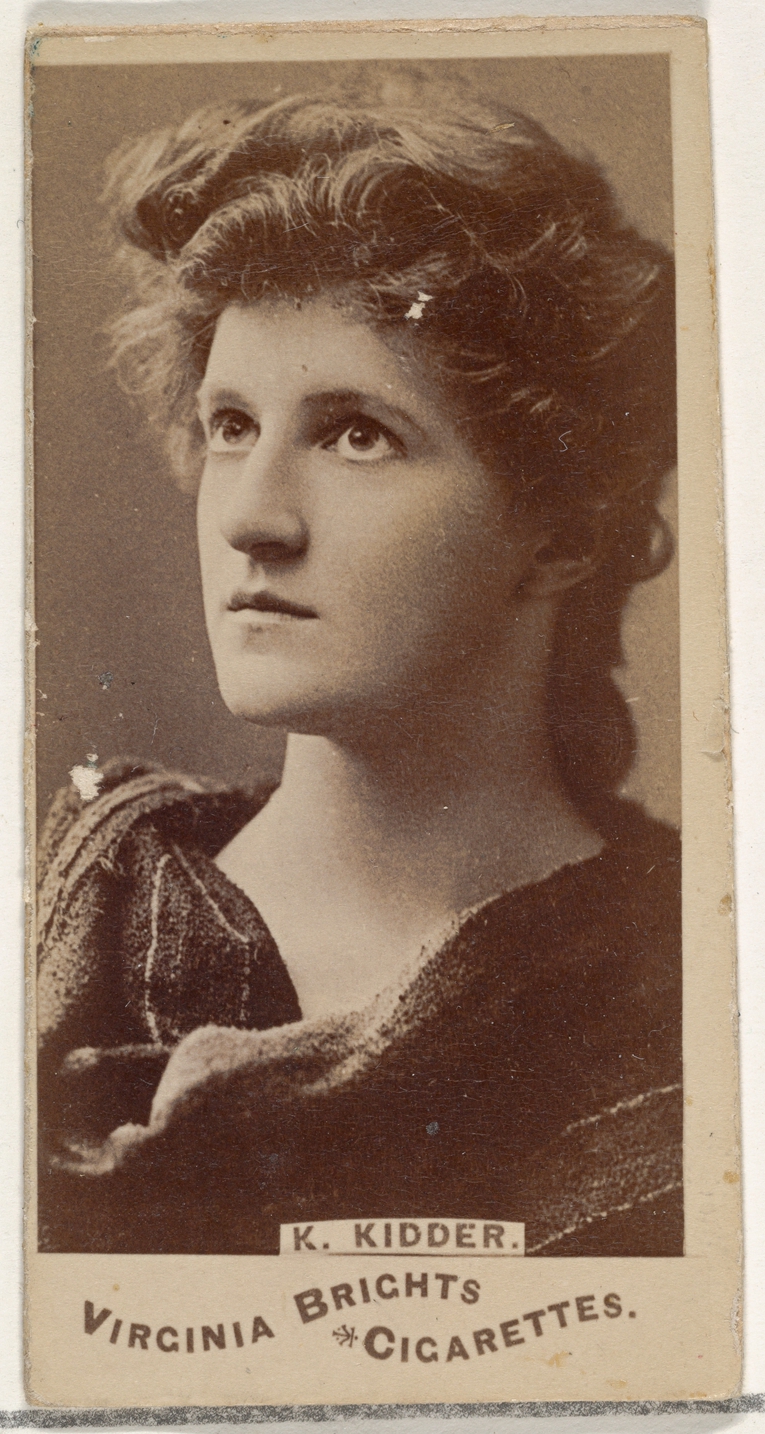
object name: photograph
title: K. Kidder, from the Actors and Actresses series (N45, Type 1) for Virginia Brights Cigarettes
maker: allen & ginter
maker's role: publisher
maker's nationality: american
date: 1888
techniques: albumen silver print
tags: portraits,women,actresses